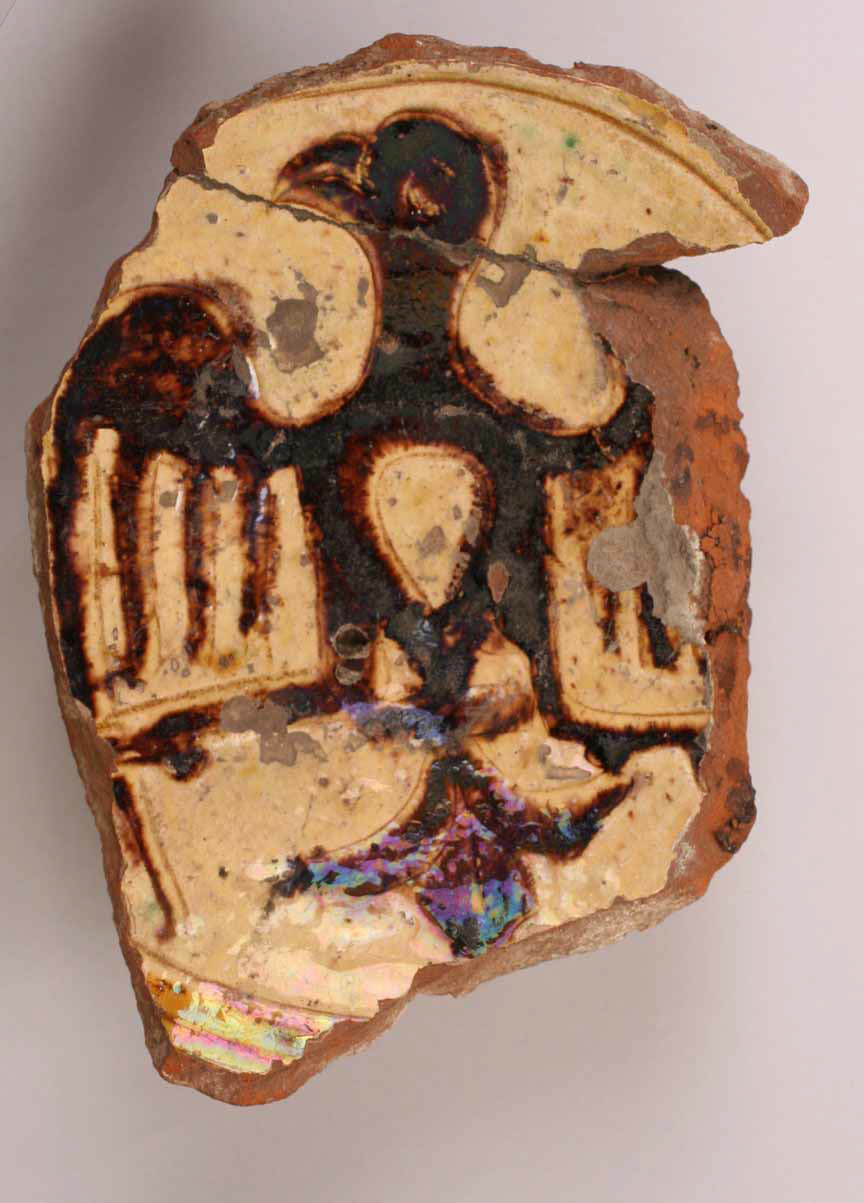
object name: fragment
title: Ceramic Fragment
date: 1301-1500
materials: earthenware, glaze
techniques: coloring, incising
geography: egypt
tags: birds